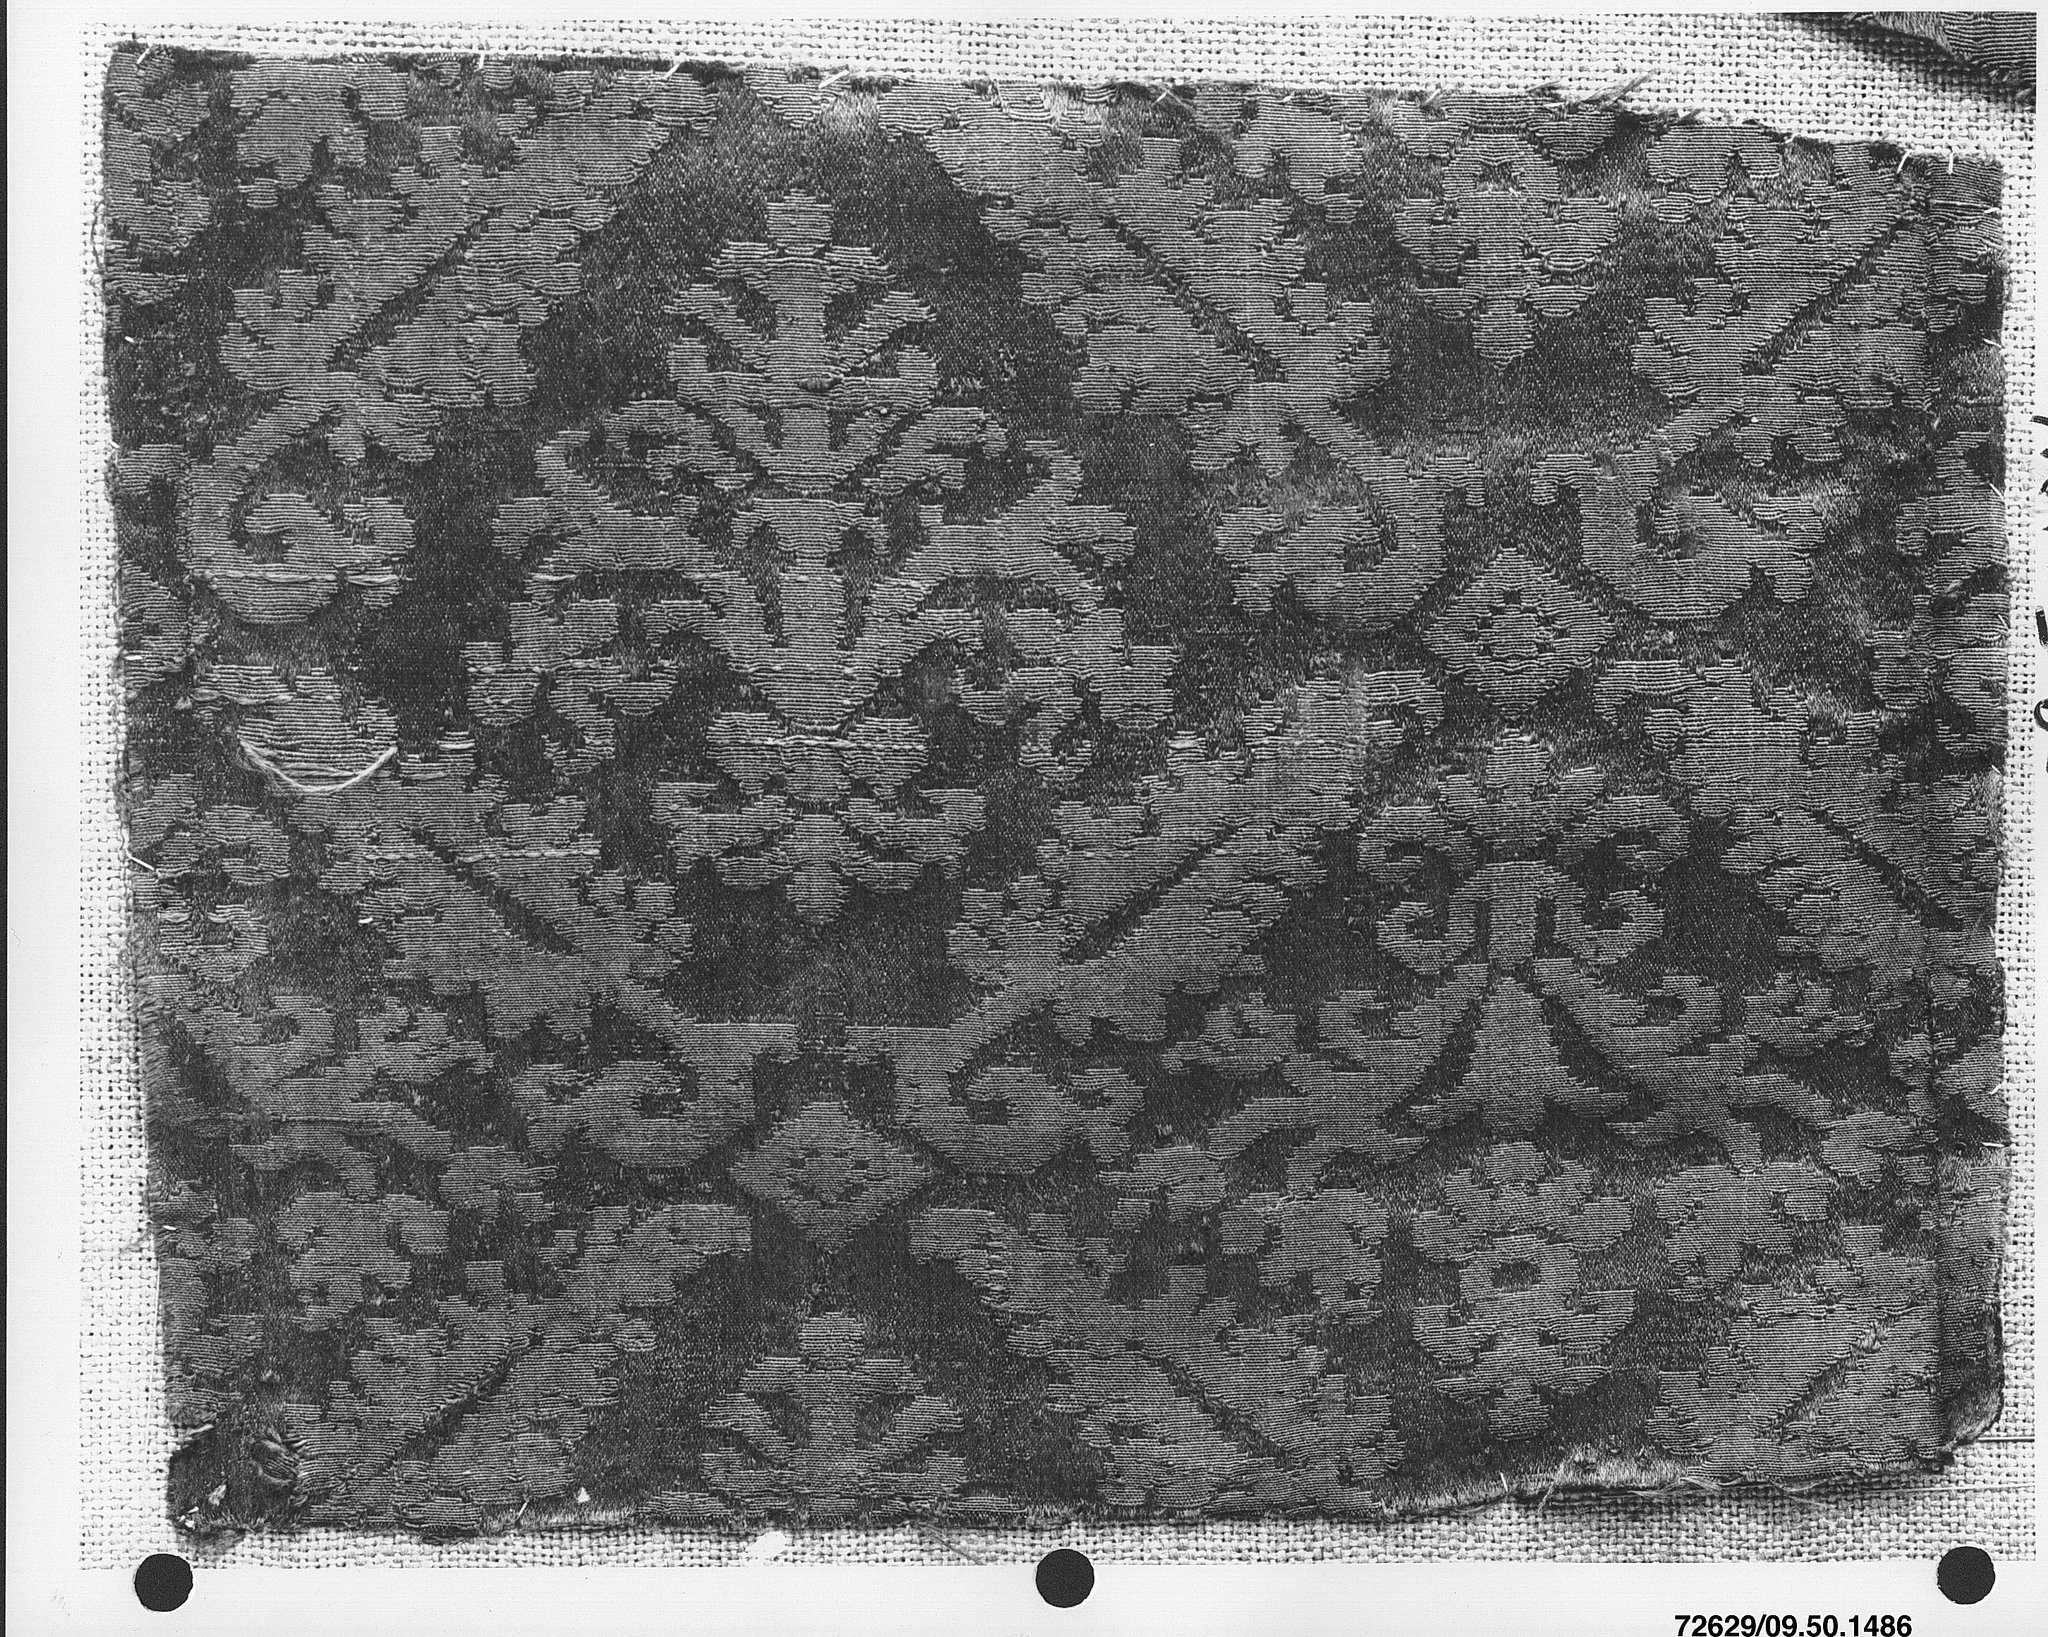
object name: piece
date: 1501-1600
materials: silk